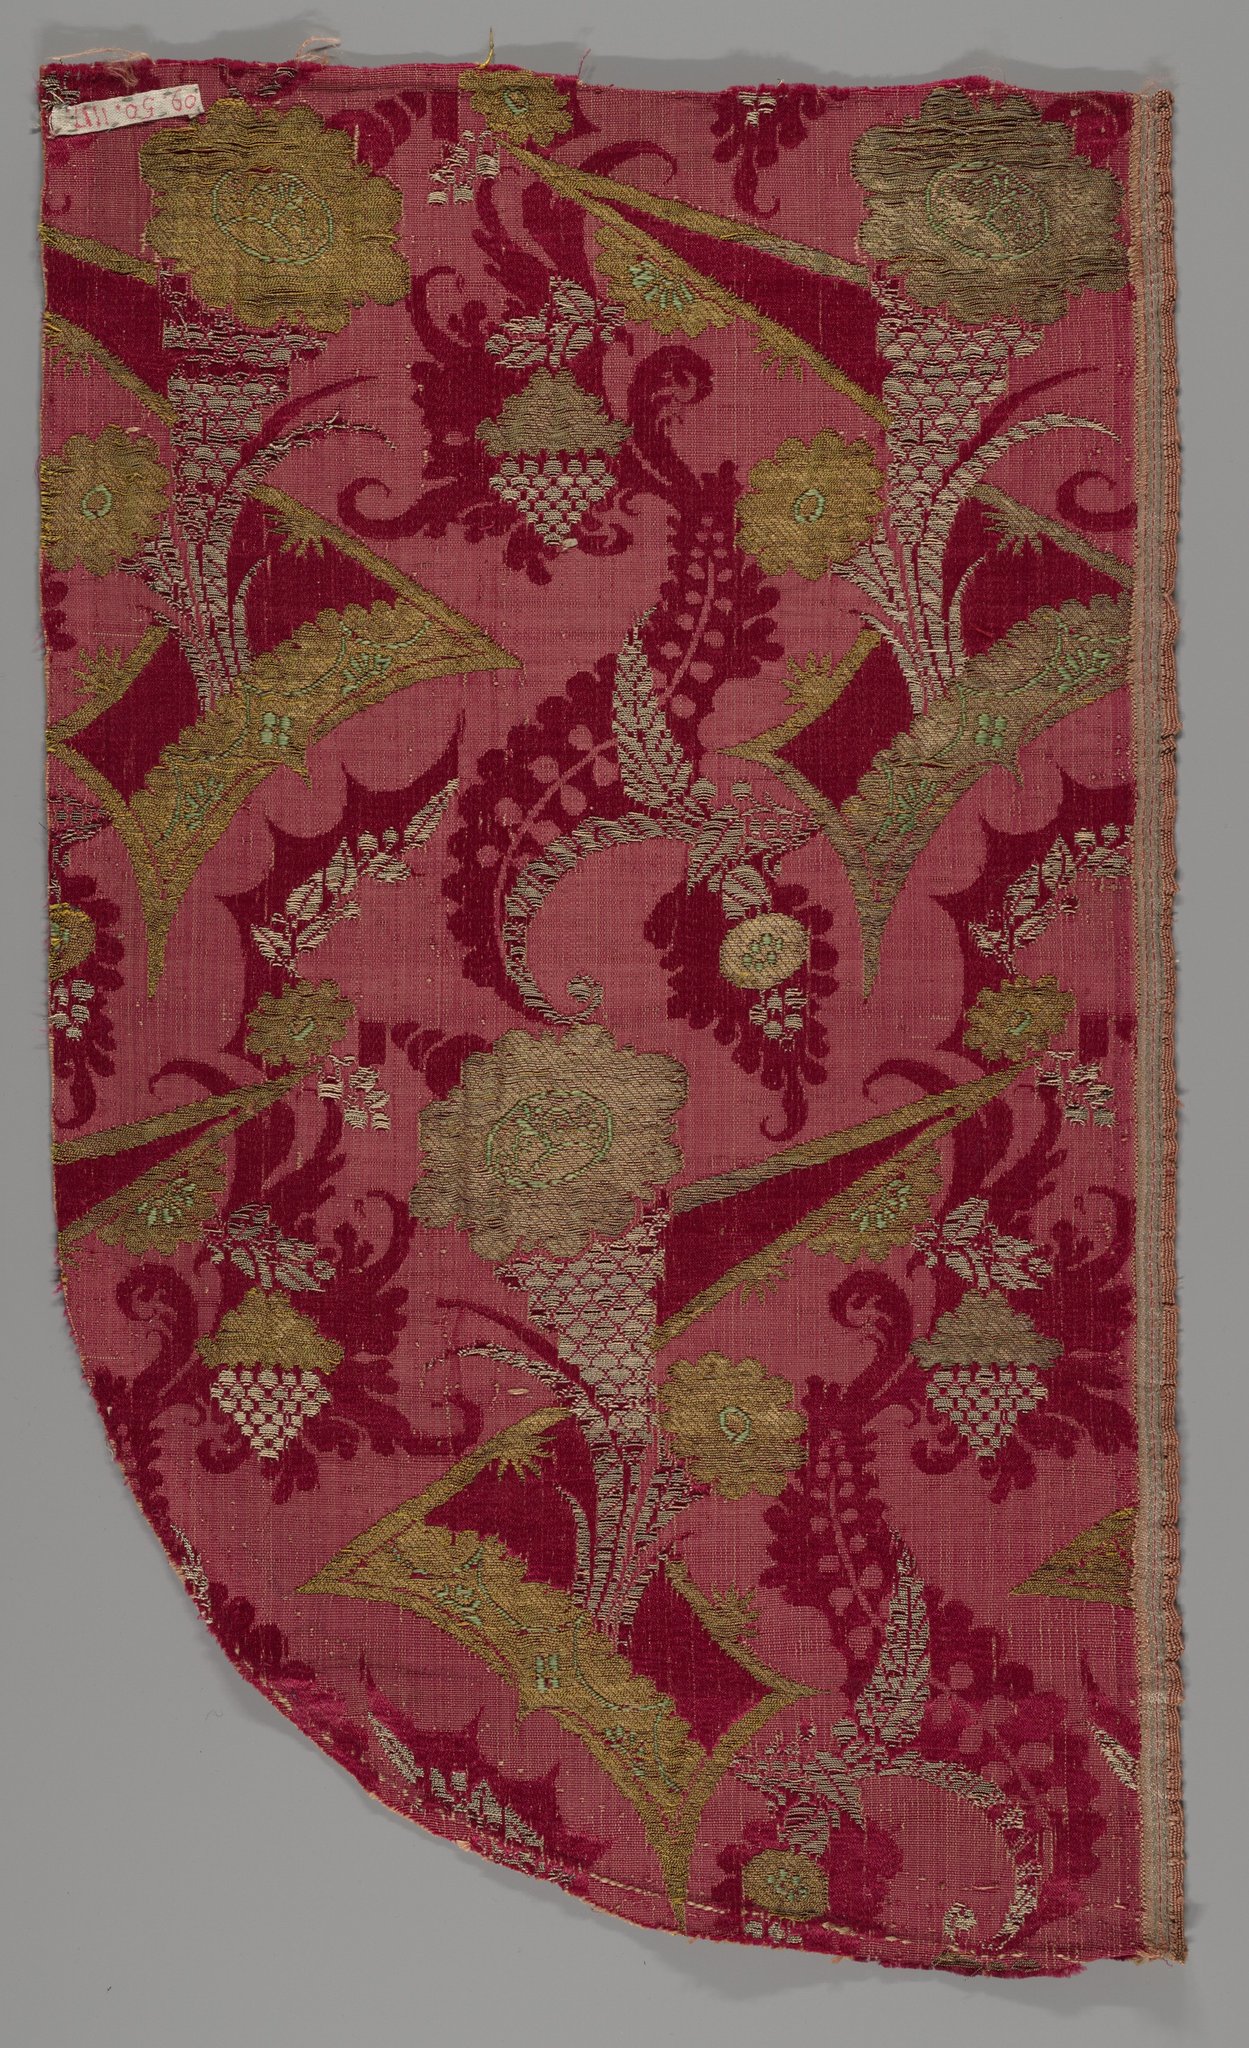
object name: piece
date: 1667-1733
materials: metal thread, silk